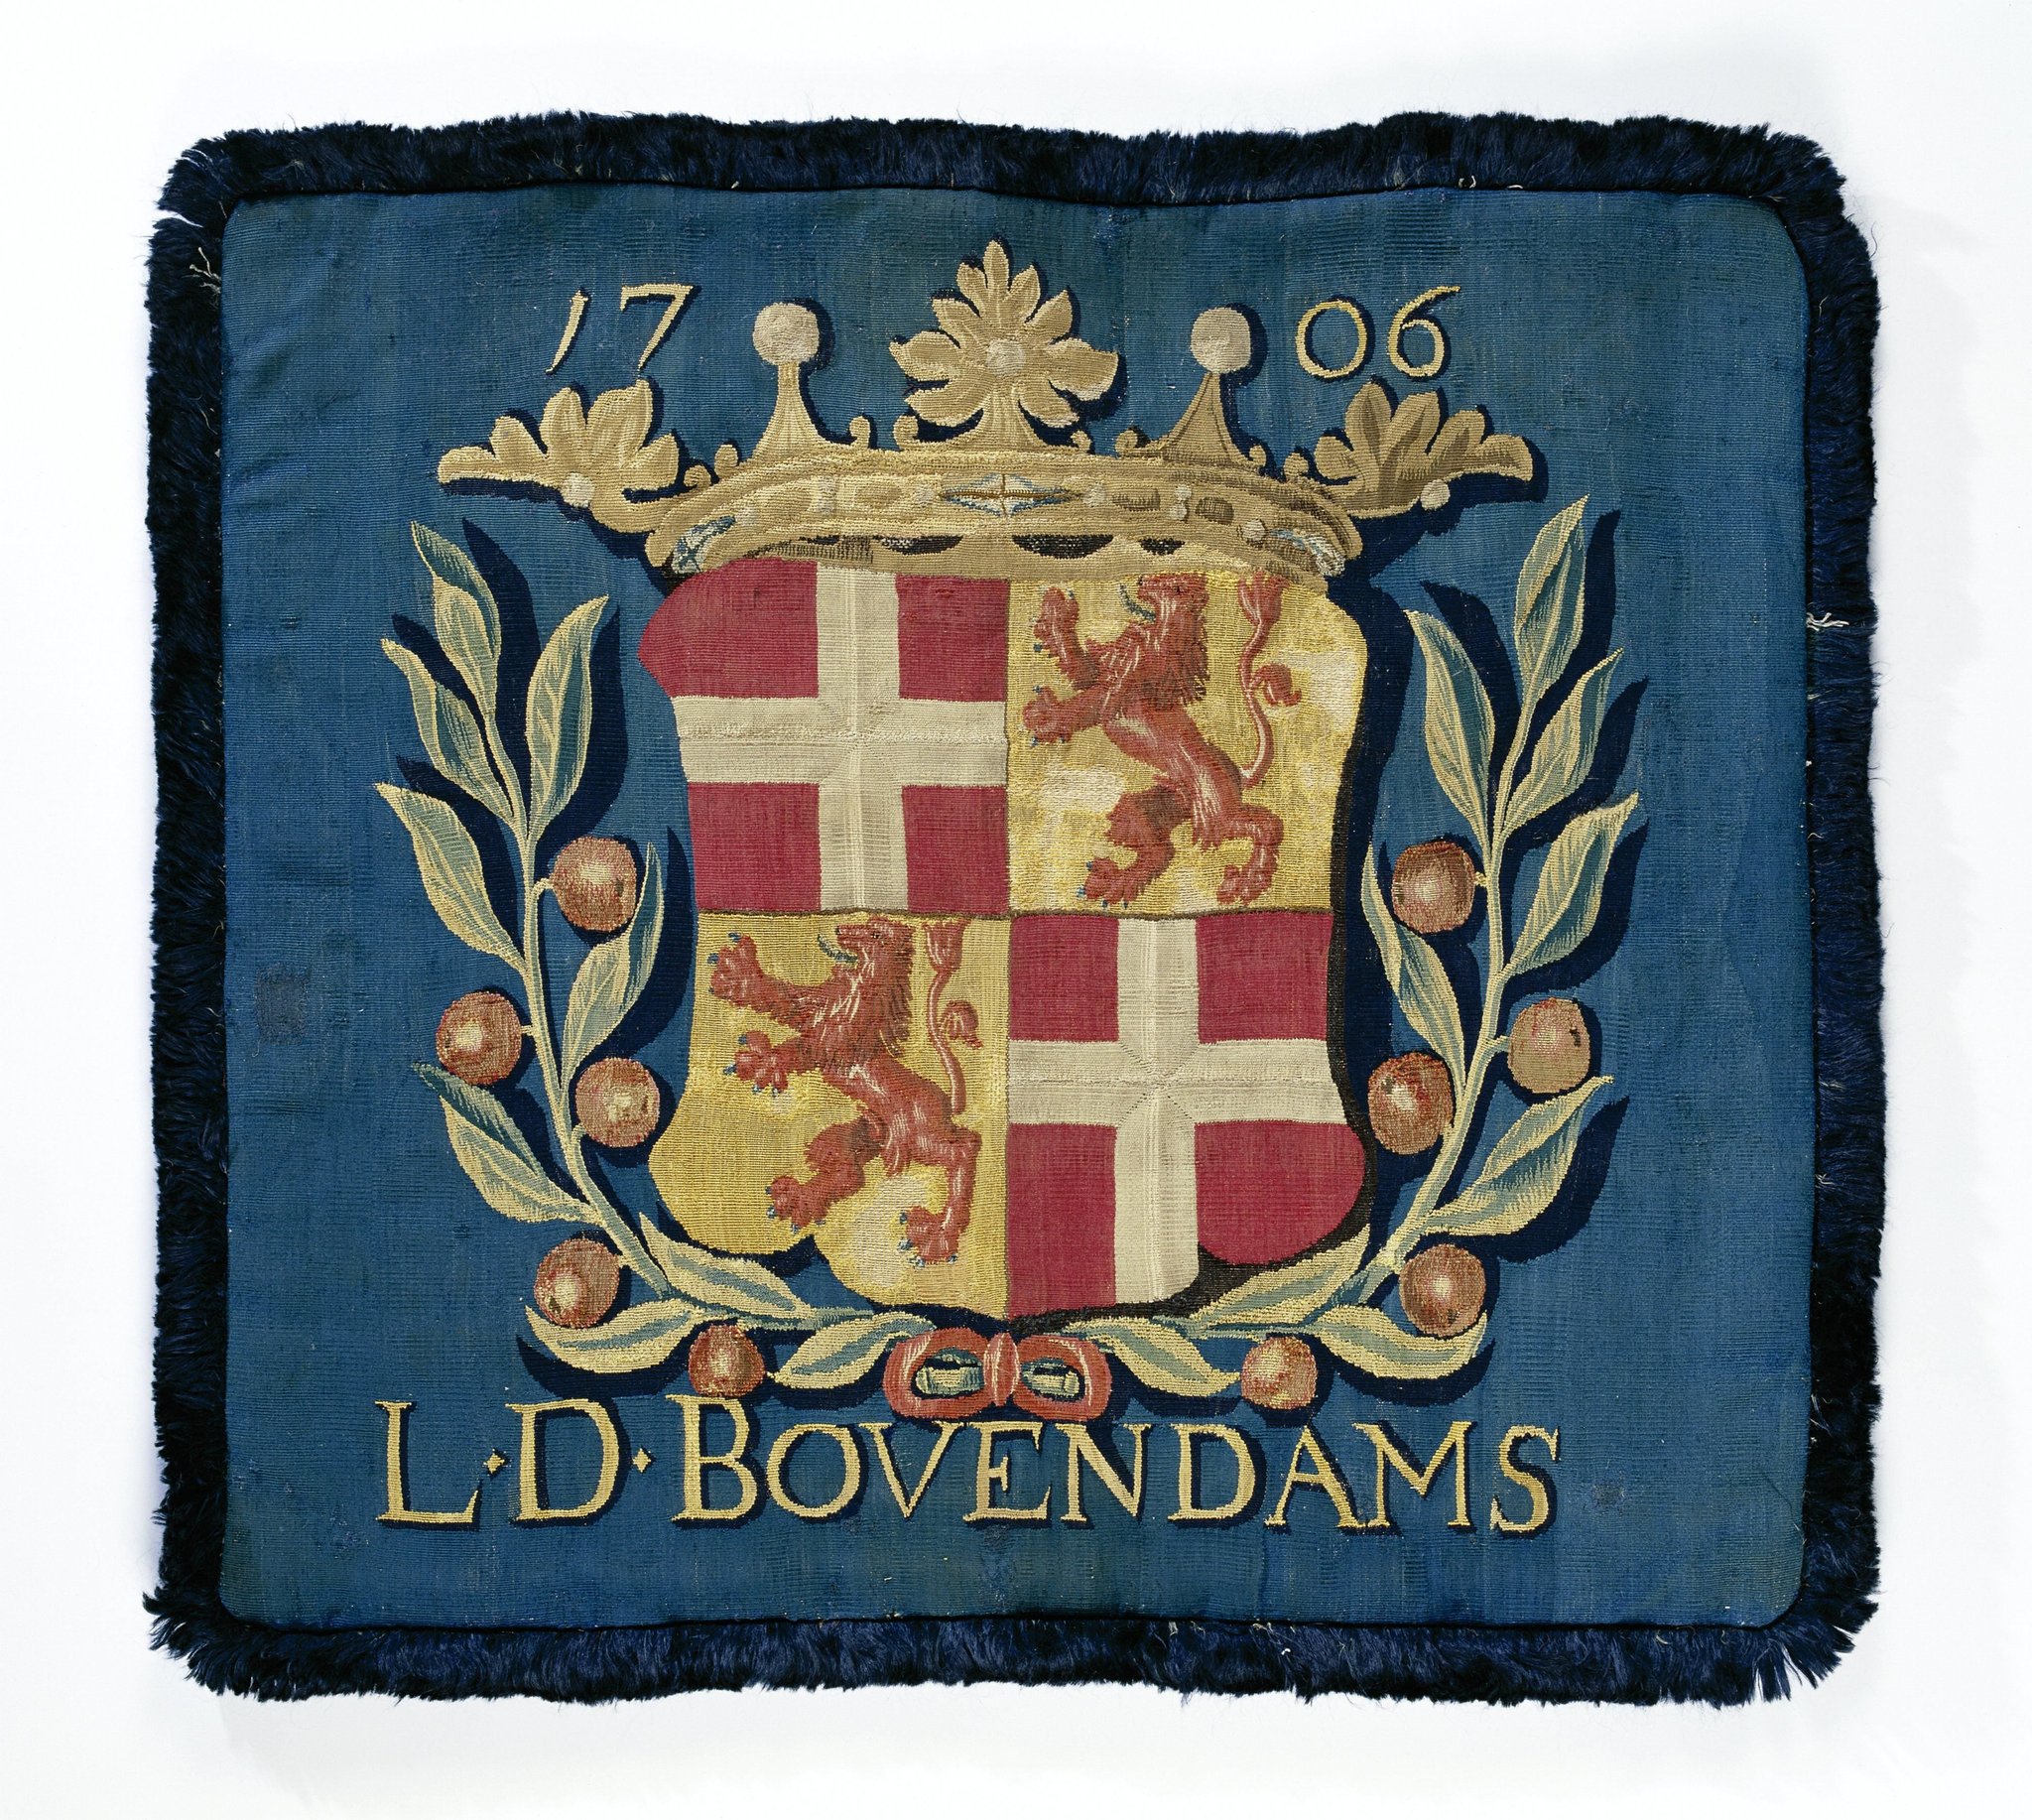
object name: cushion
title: Kussen met het wapen van het waterschap Lekdijk Bovendams (van de rivier de Lek boven de dam)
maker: Anonymous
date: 1706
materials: silk, wool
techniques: tapestry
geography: schoonhoven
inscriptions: date: ‘1706’, inscription: ‘L.D. BOVENDAMS’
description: Magistratenkussen van tapijtweefsel met het gekroonde wapen van Utrecht en de inscriptie "L.D. Bovendams" Lekdijk Bovendams en het jaartal 1706.